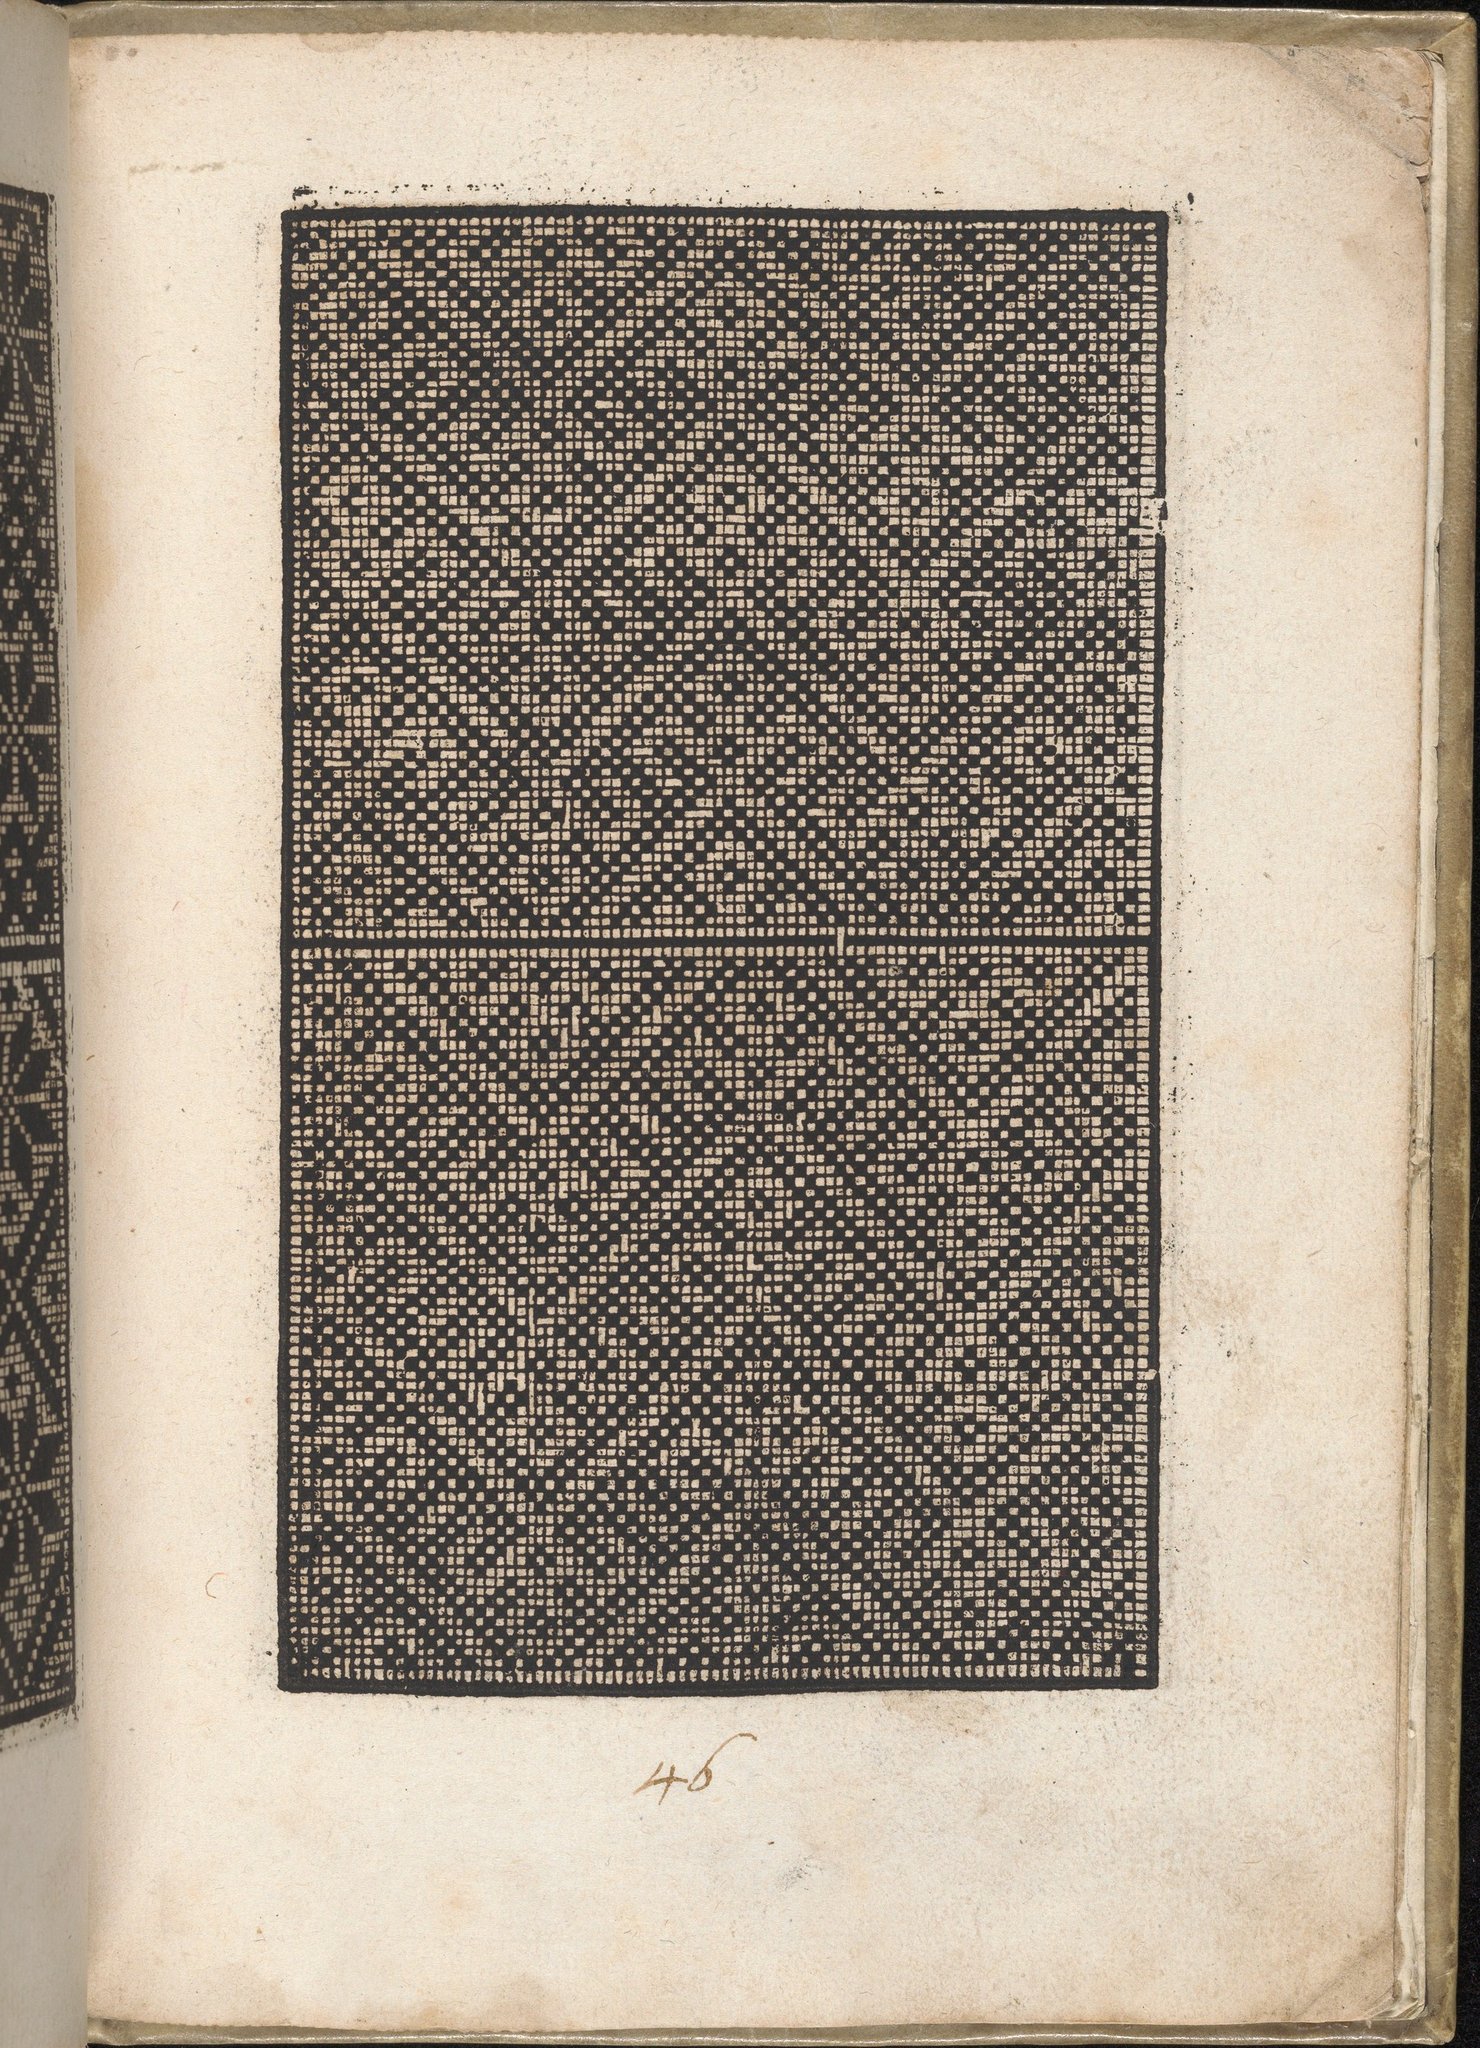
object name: book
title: Page 19v, from "Eyn New Kunstlichboich"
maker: peter quentel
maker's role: publisher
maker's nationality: german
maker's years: 1500-1550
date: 1529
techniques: woodcut